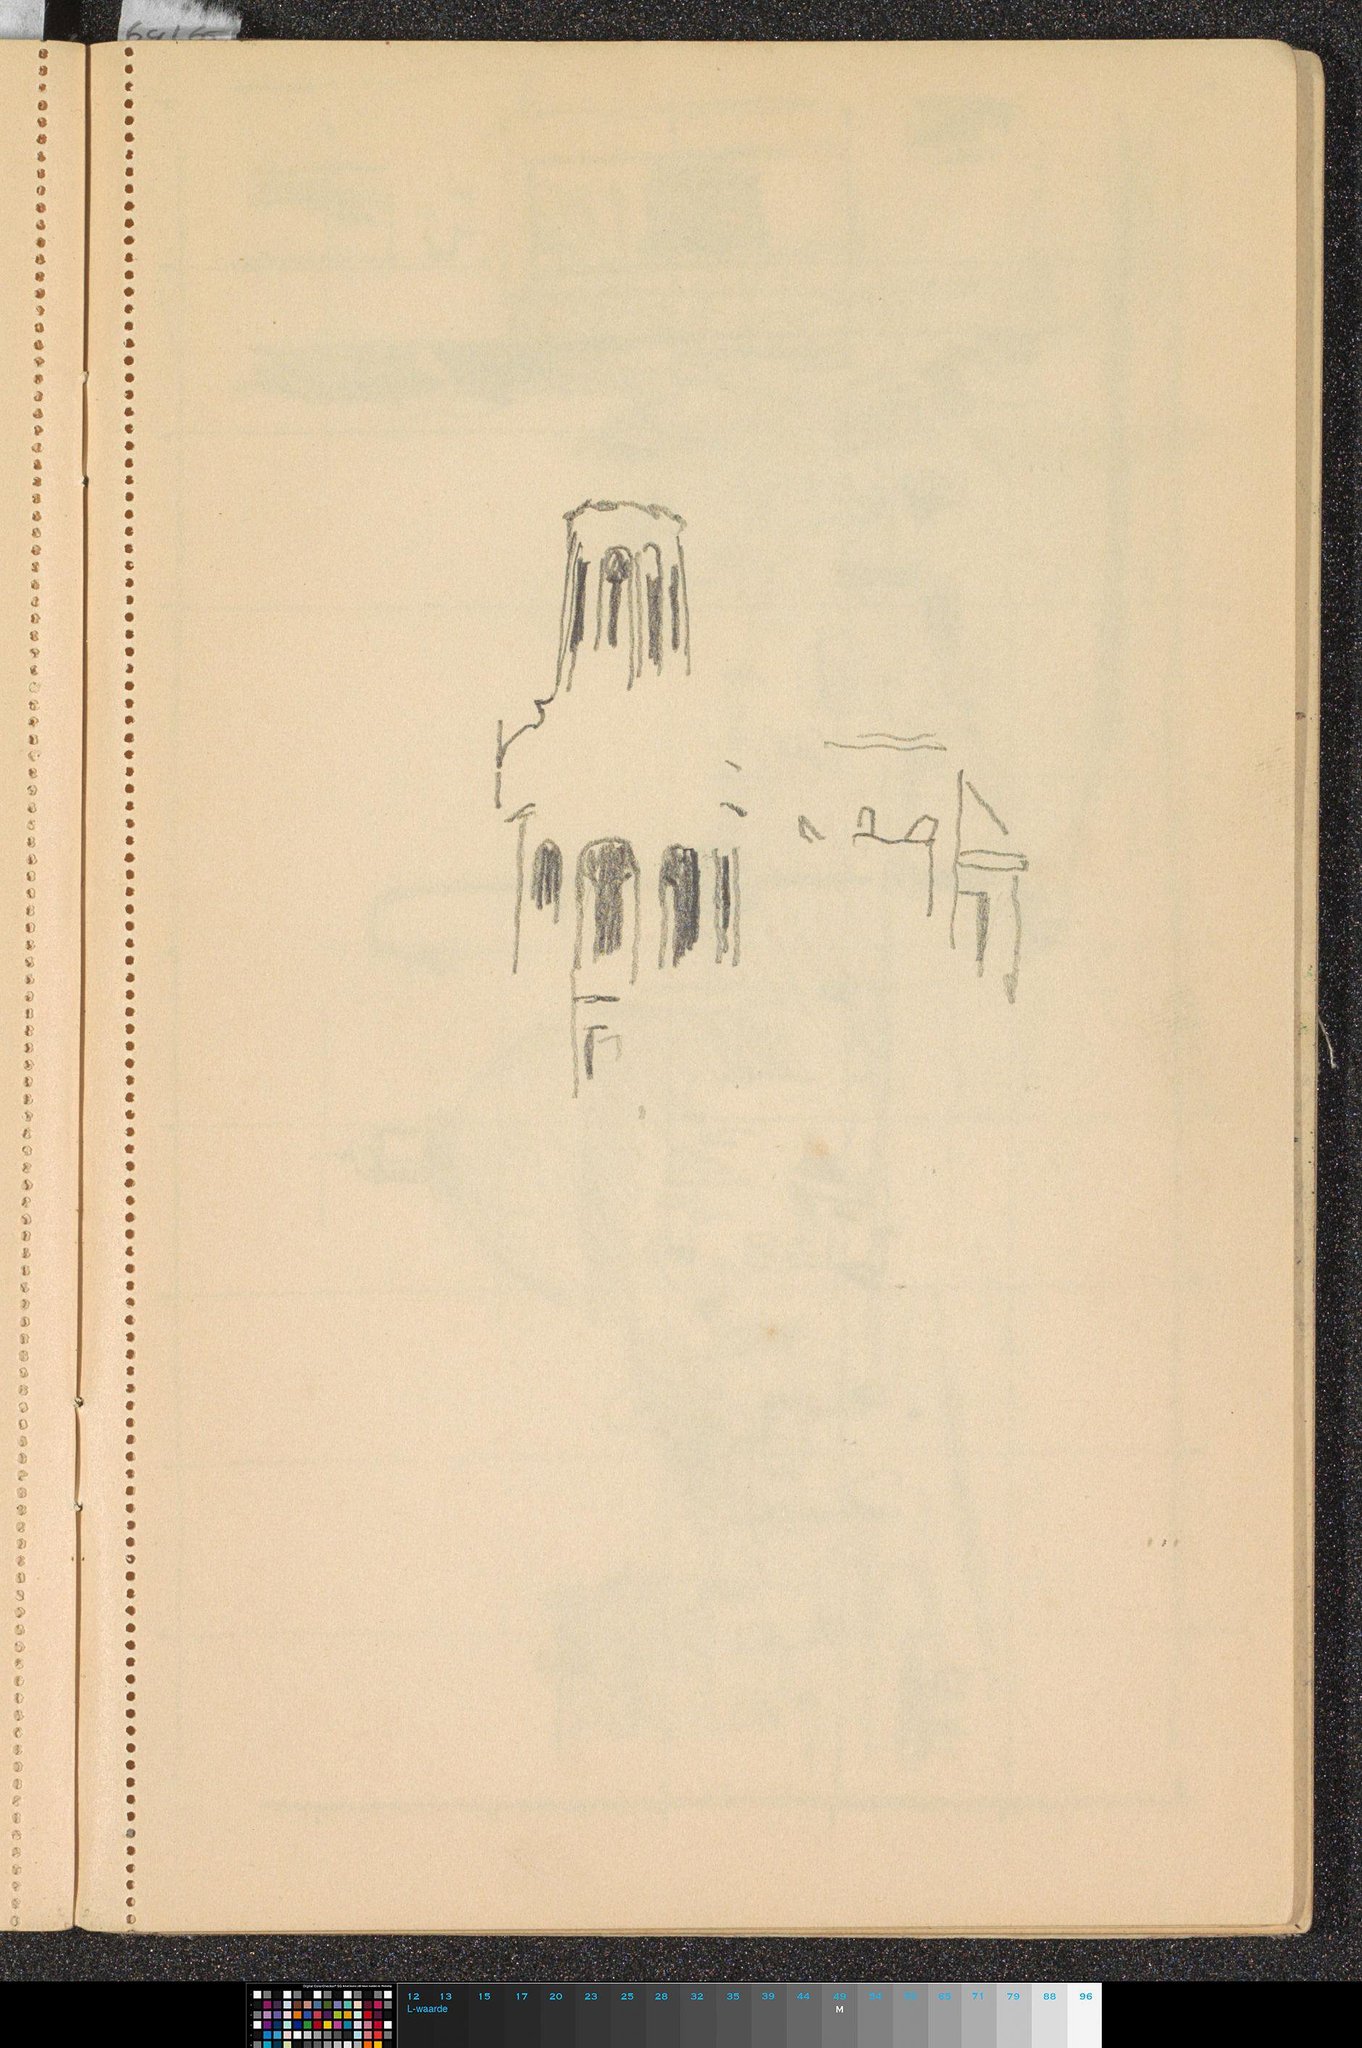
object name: sketchbook leaf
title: Gebouw met een toren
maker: cornelis vreedenburgh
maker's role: draughtsman, print maker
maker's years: 1880-1946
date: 1890-1946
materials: paper, pencil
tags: tower (of house or building)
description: Blad 62 recto uit een schetsboek met 73 bladen.